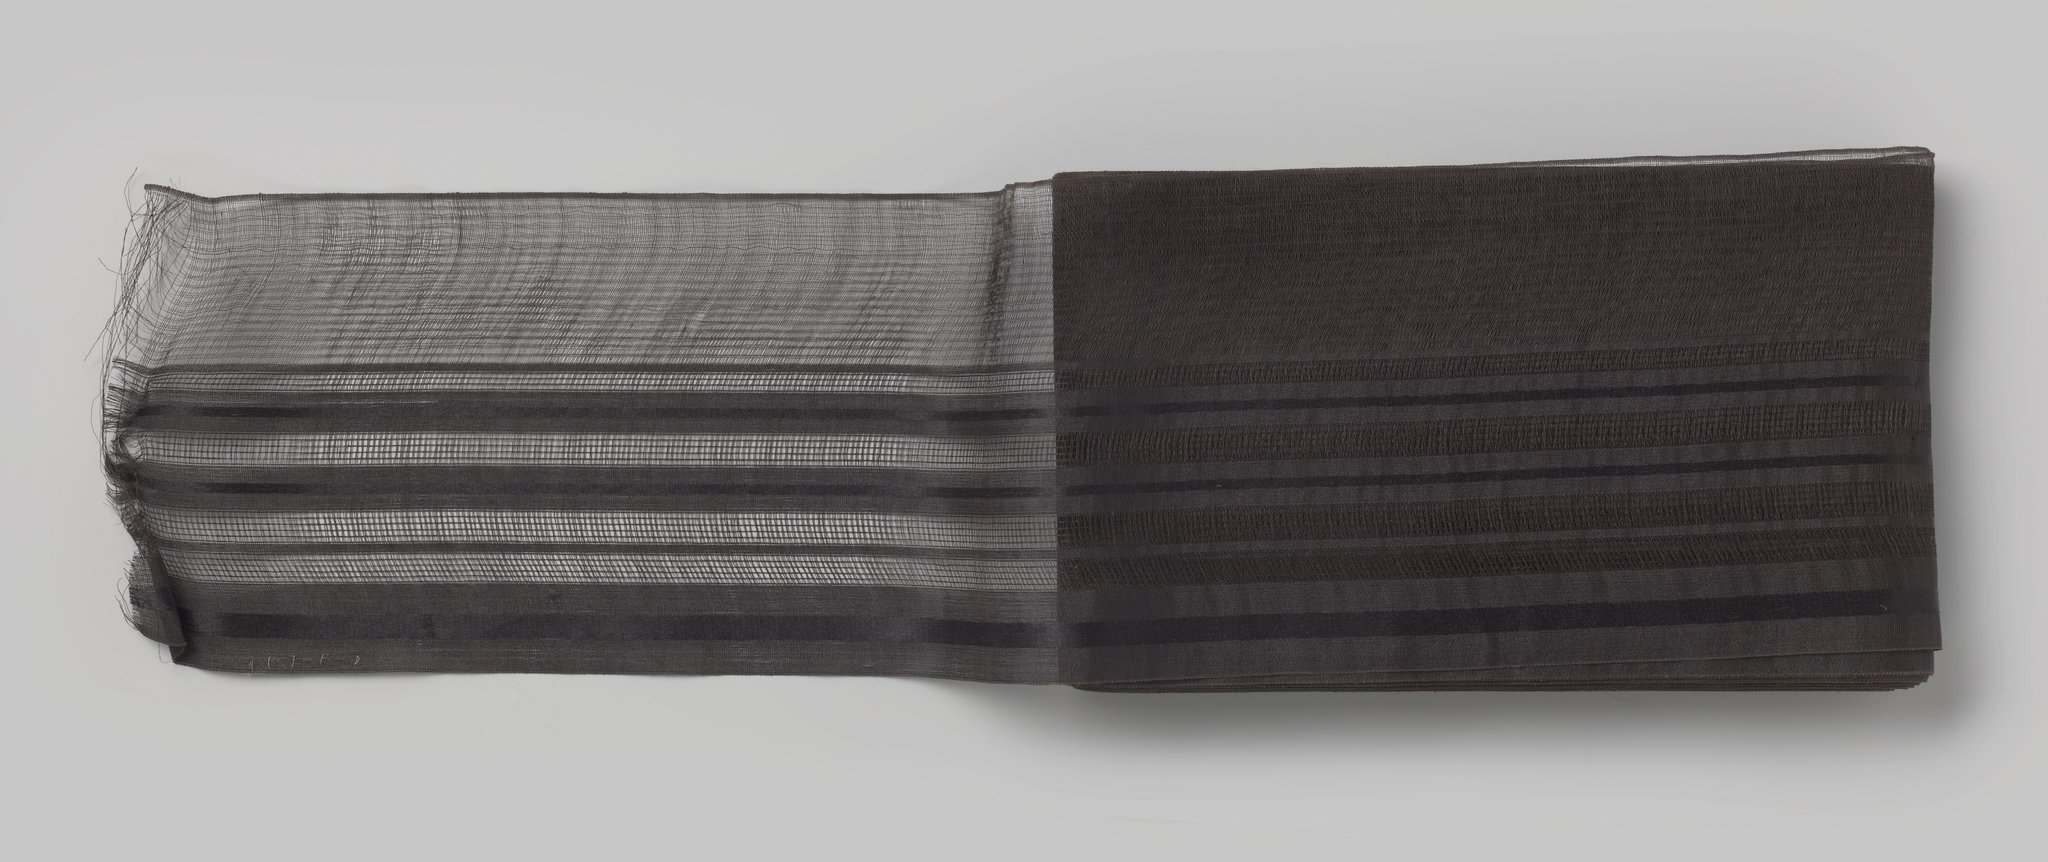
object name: braid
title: Metrage lint van zwart zijden gaas, met ingeweven horizontale lijnen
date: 1900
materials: silk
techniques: weave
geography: nijmegen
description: Metrage lint van zwart zijden gaas, met ingeweven horizontale lijnen